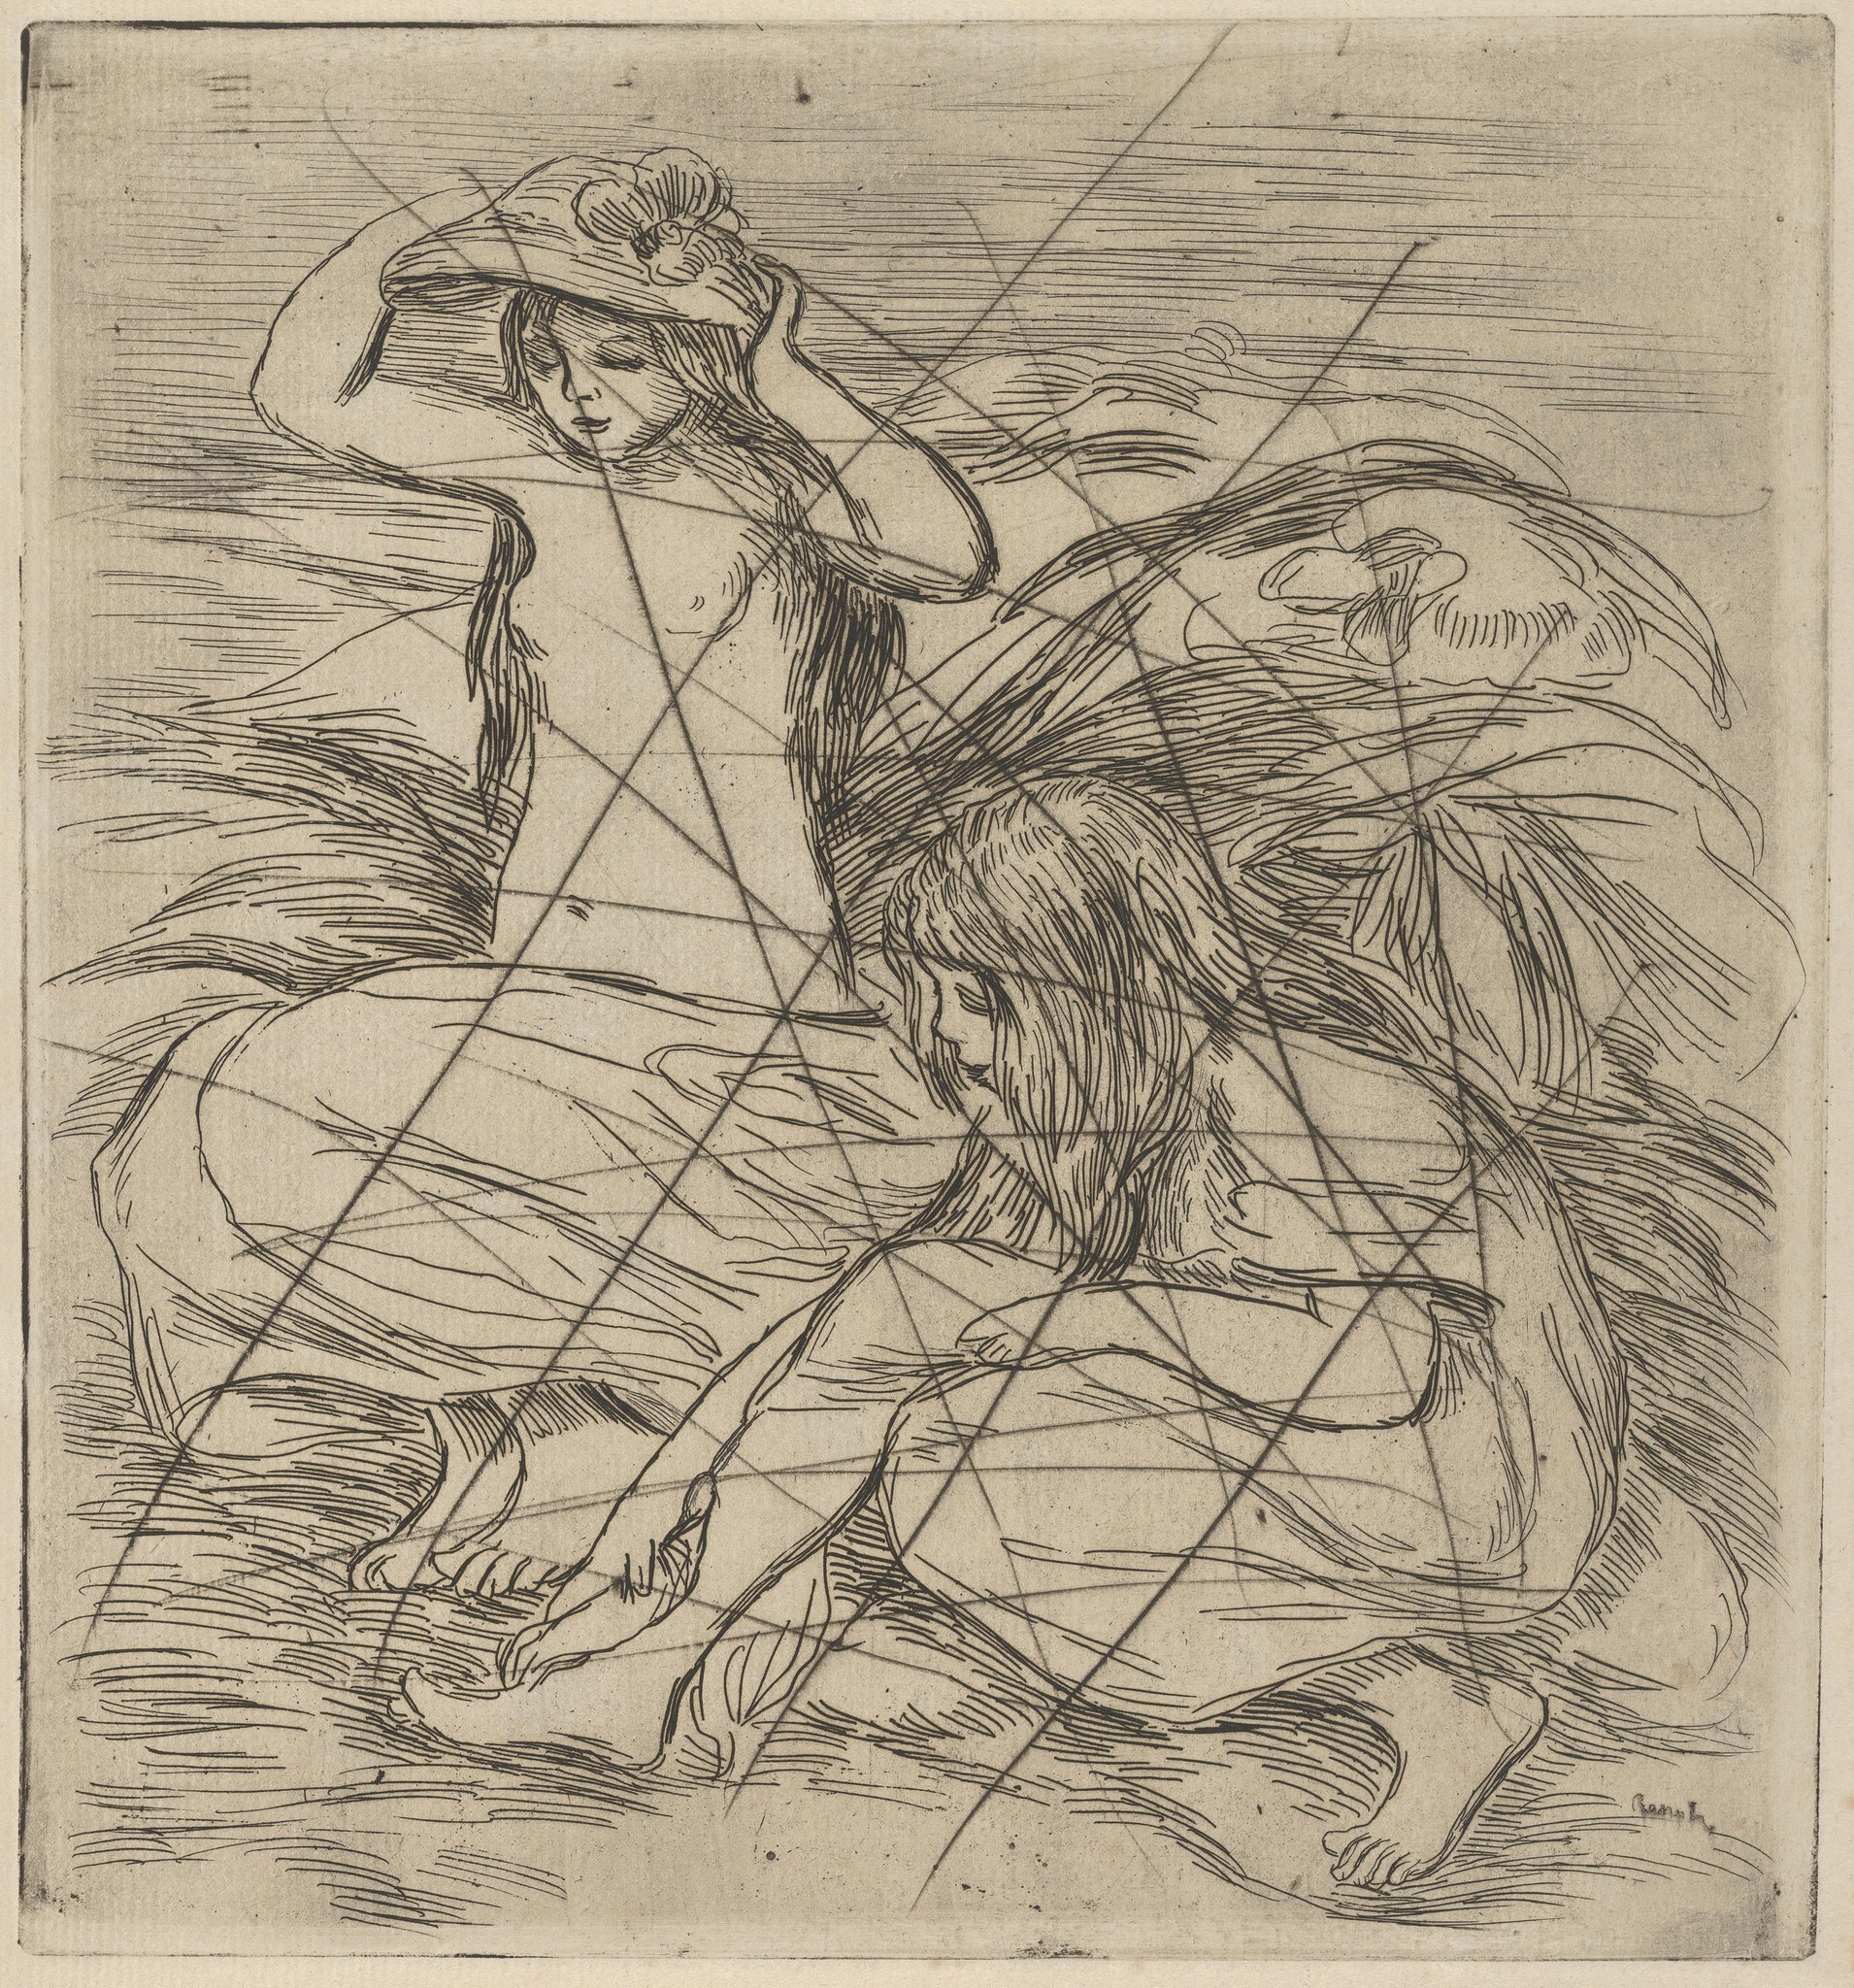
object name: print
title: Les Deux Baigneuses (Cancelled impression)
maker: pierre auguste renoir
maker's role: artist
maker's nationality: french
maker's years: 1841-1919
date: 1895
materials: paper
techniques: etching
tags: female nudes,bathing